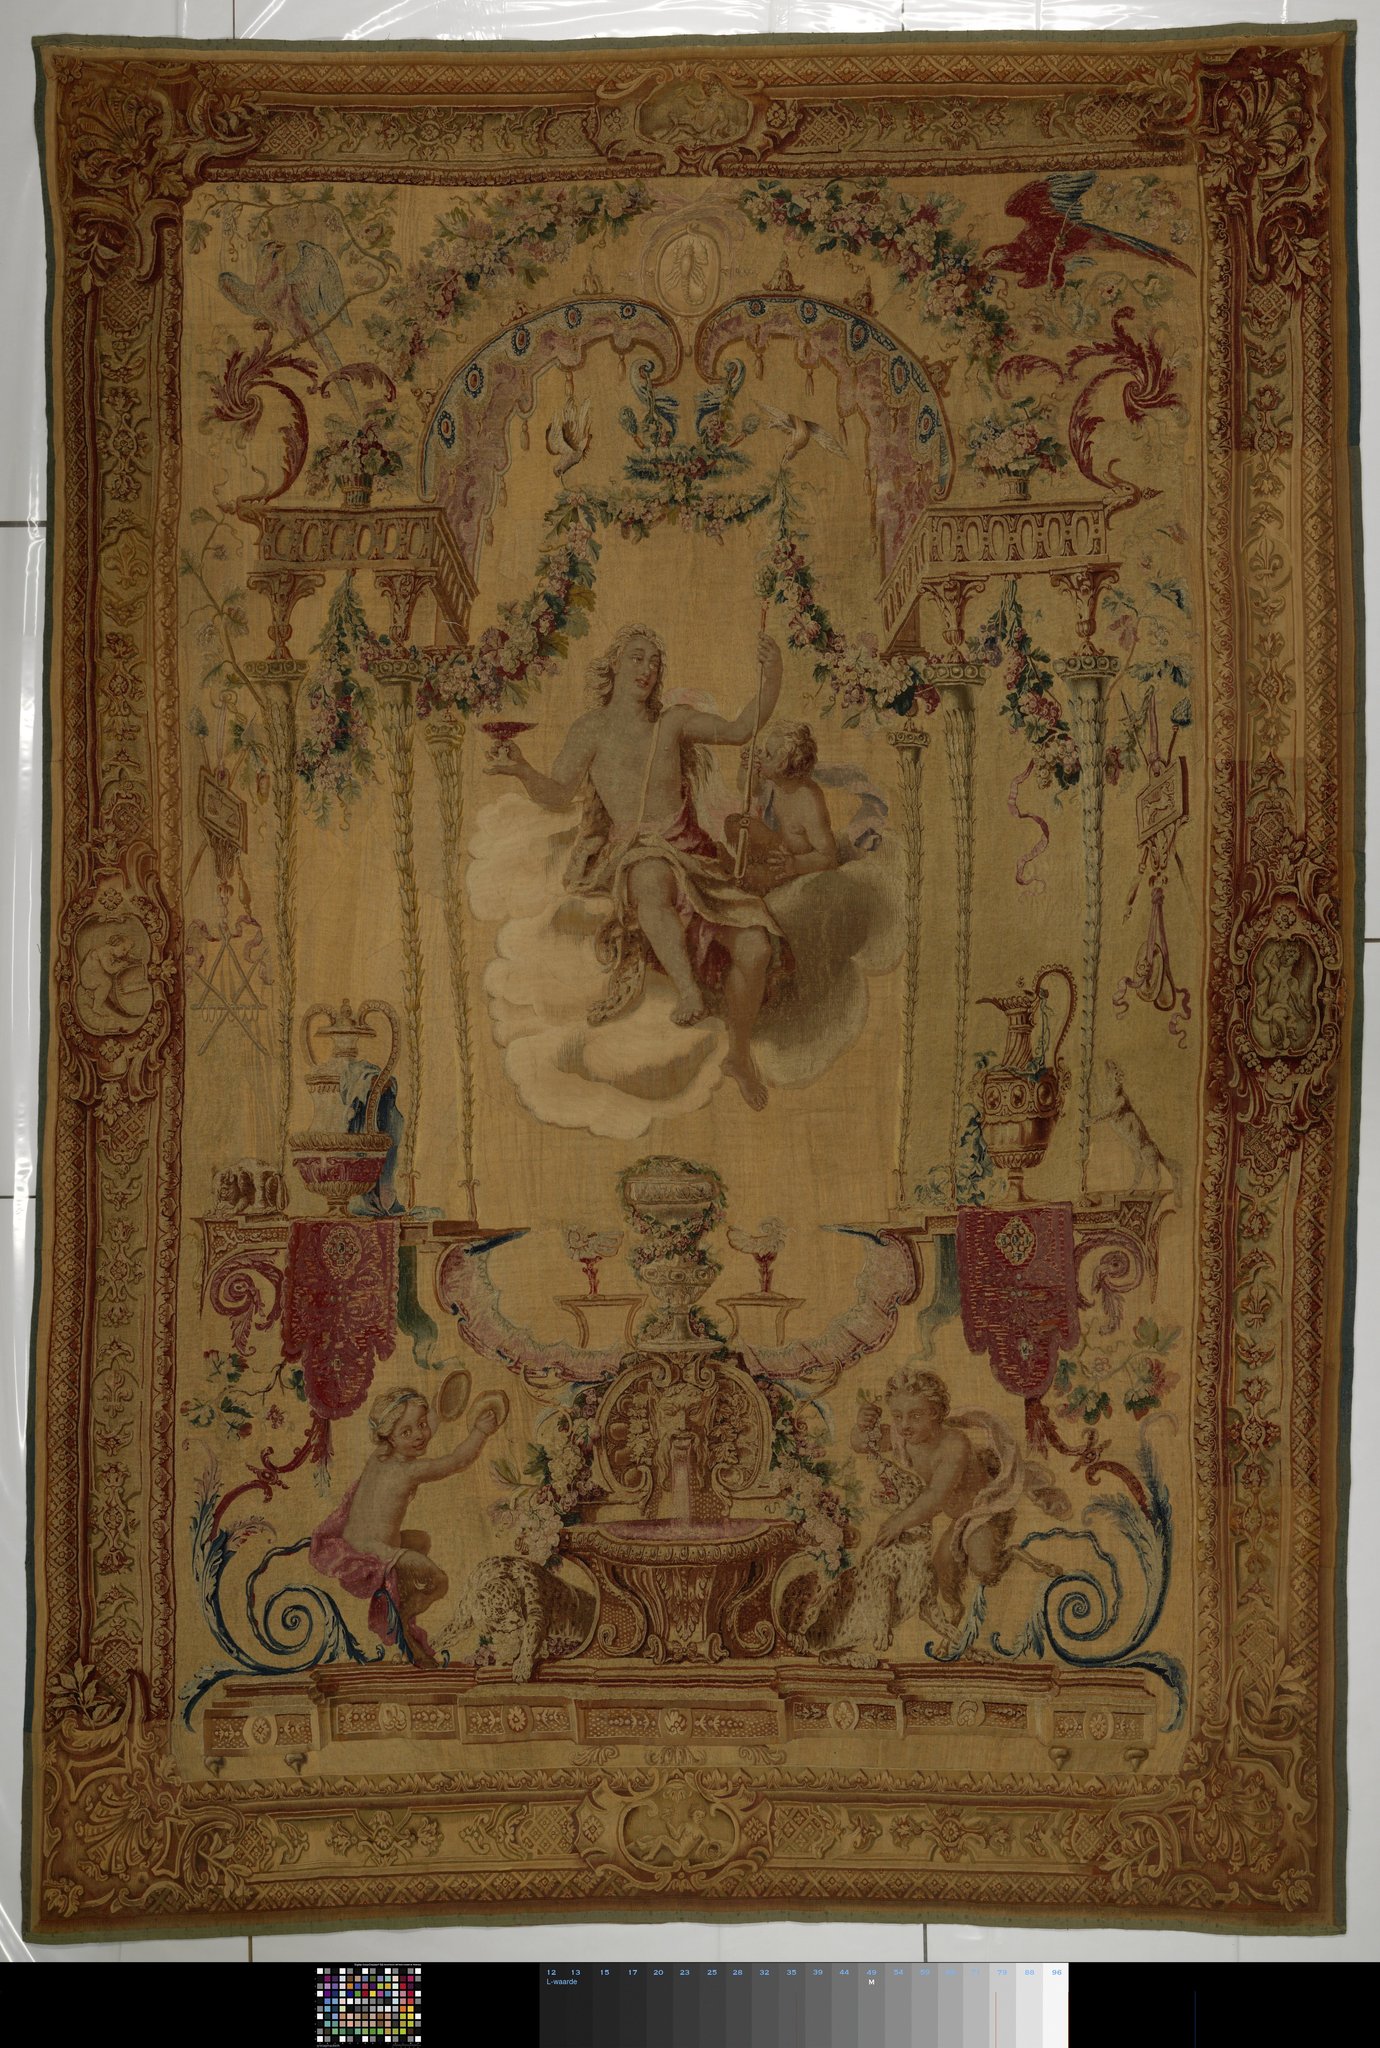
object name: portière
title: Wandtapijt met Bacchus als personificatie van de herfst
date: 1722-1728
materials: silk, wool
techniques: tapestry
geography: france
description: Portière met Bacchus, als personificatie van de herfst, omgeven door grotesken en het teken van Weegschaal, Schorpioen en Boogschutter, uit een serie van goden, seizoenen, elementen en tekens van de dierenriem.